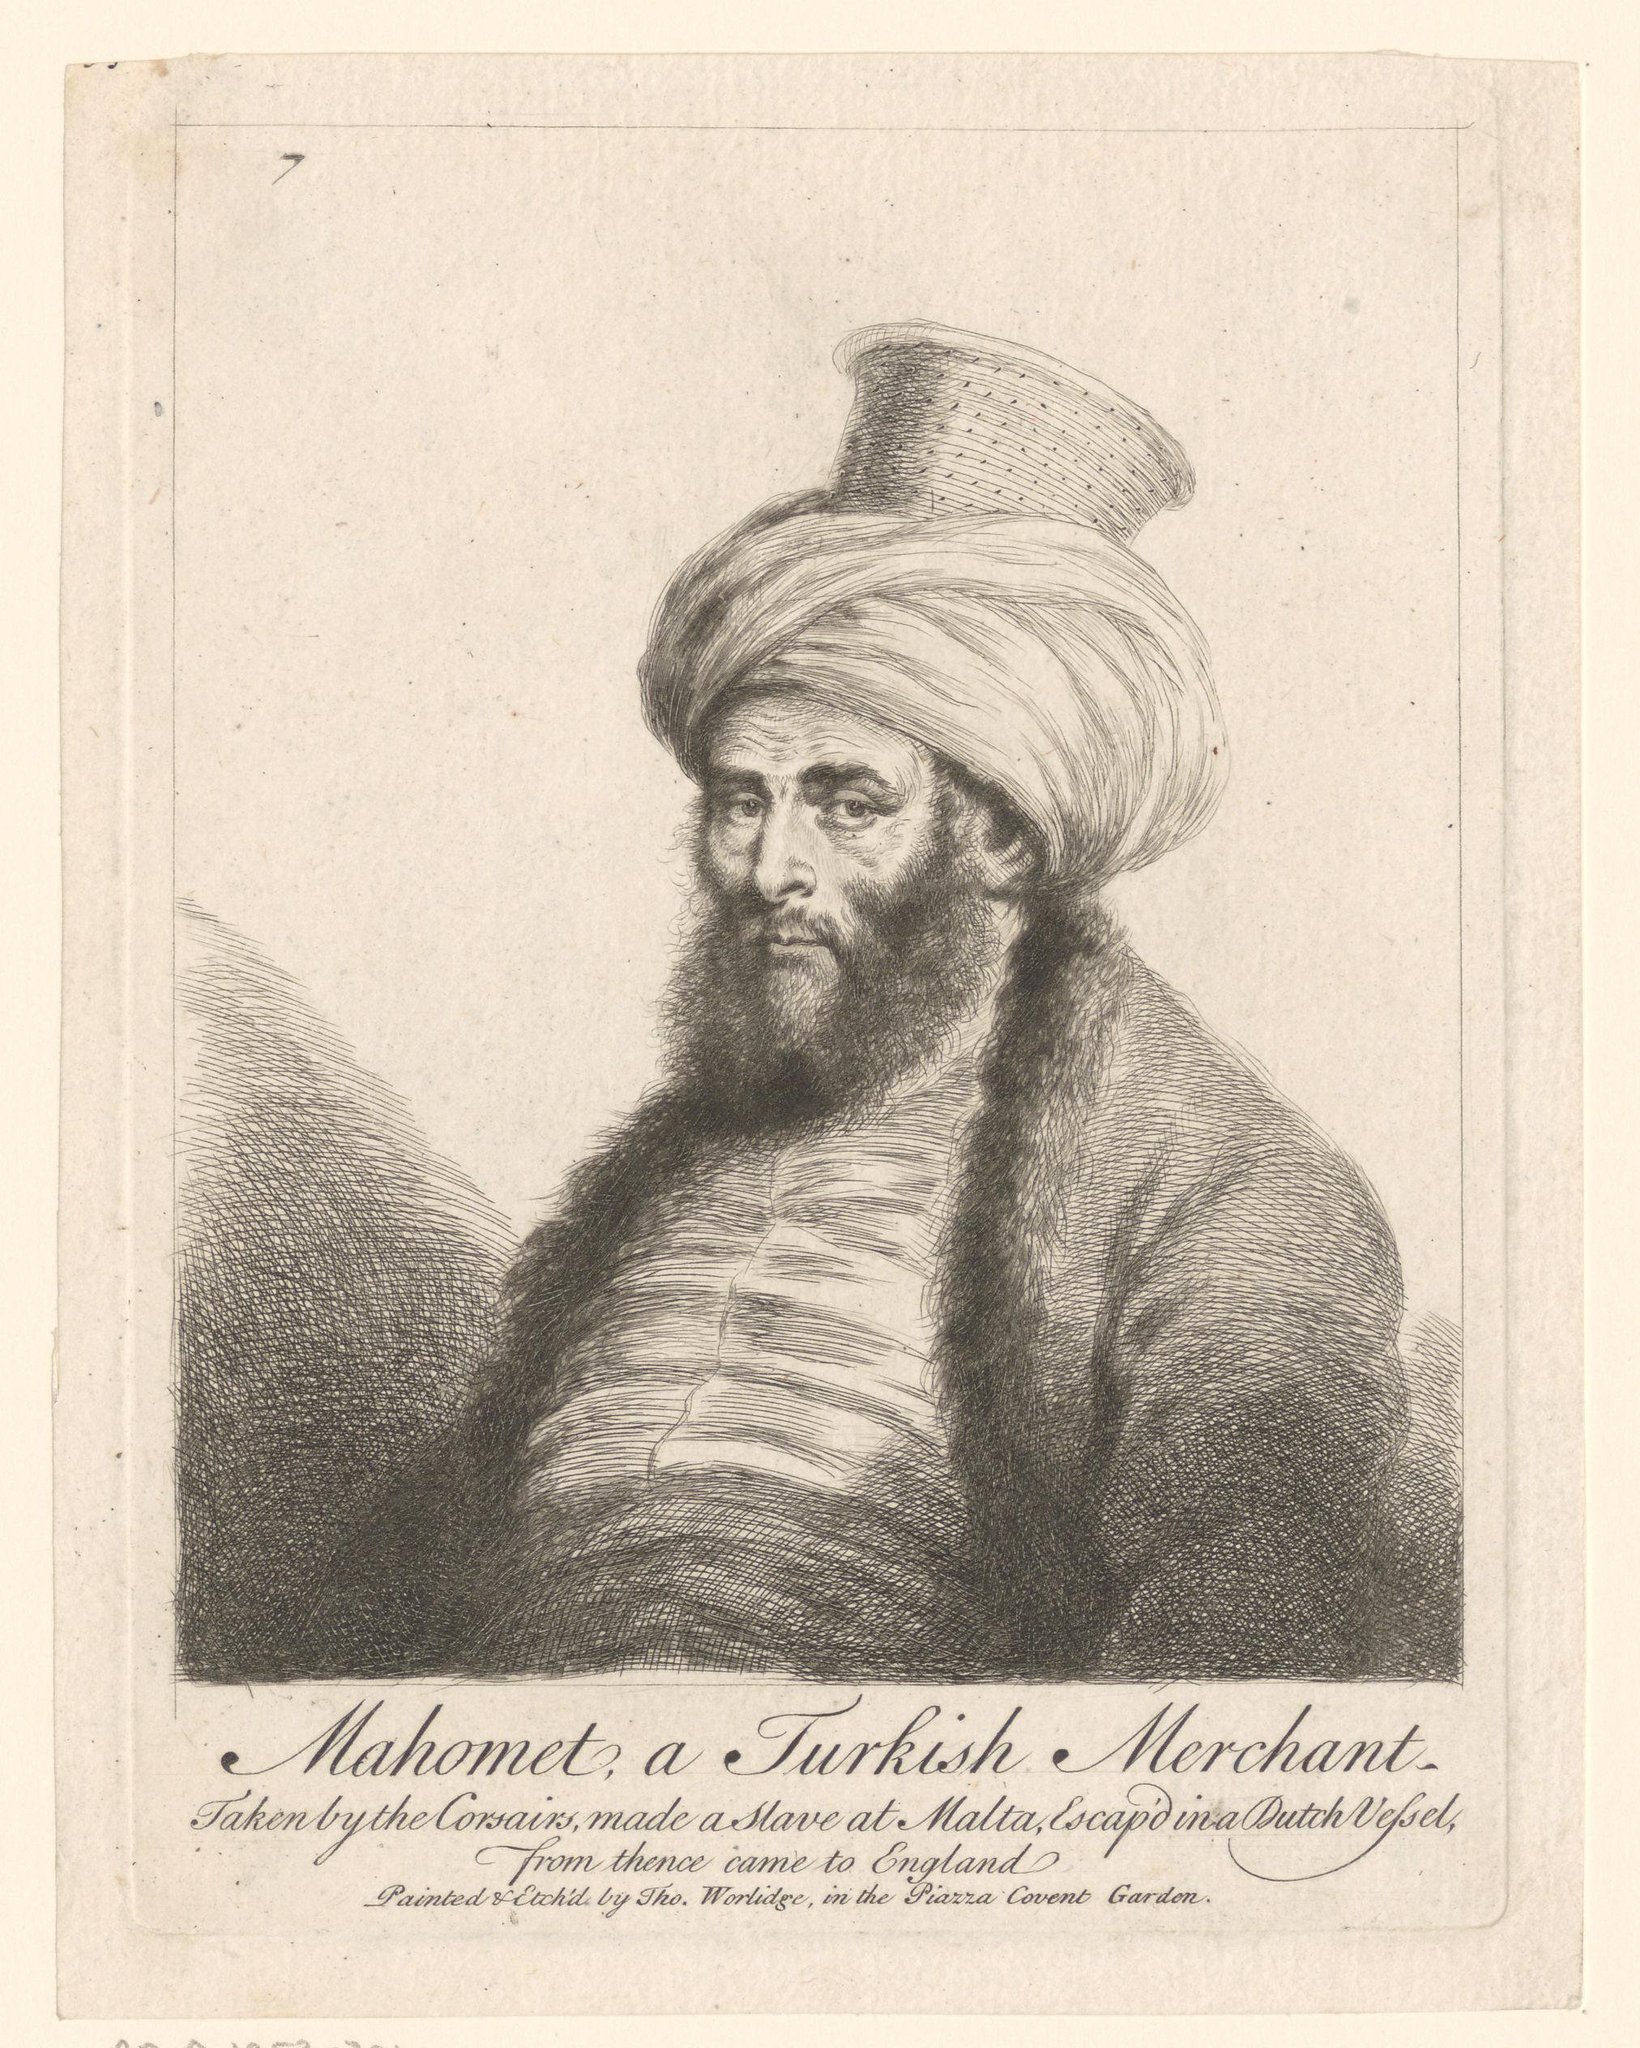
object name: print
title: Mahomet, a Turkish Merchant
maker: thomas worlidge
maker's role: print maker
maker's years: 1700-1766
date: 1710-1766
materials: paper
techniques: drypoint, etching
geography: london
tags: historical persons, merchant, salesman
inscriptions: collector's mark: Lugt 2228, collector's mark: Lugt 2760